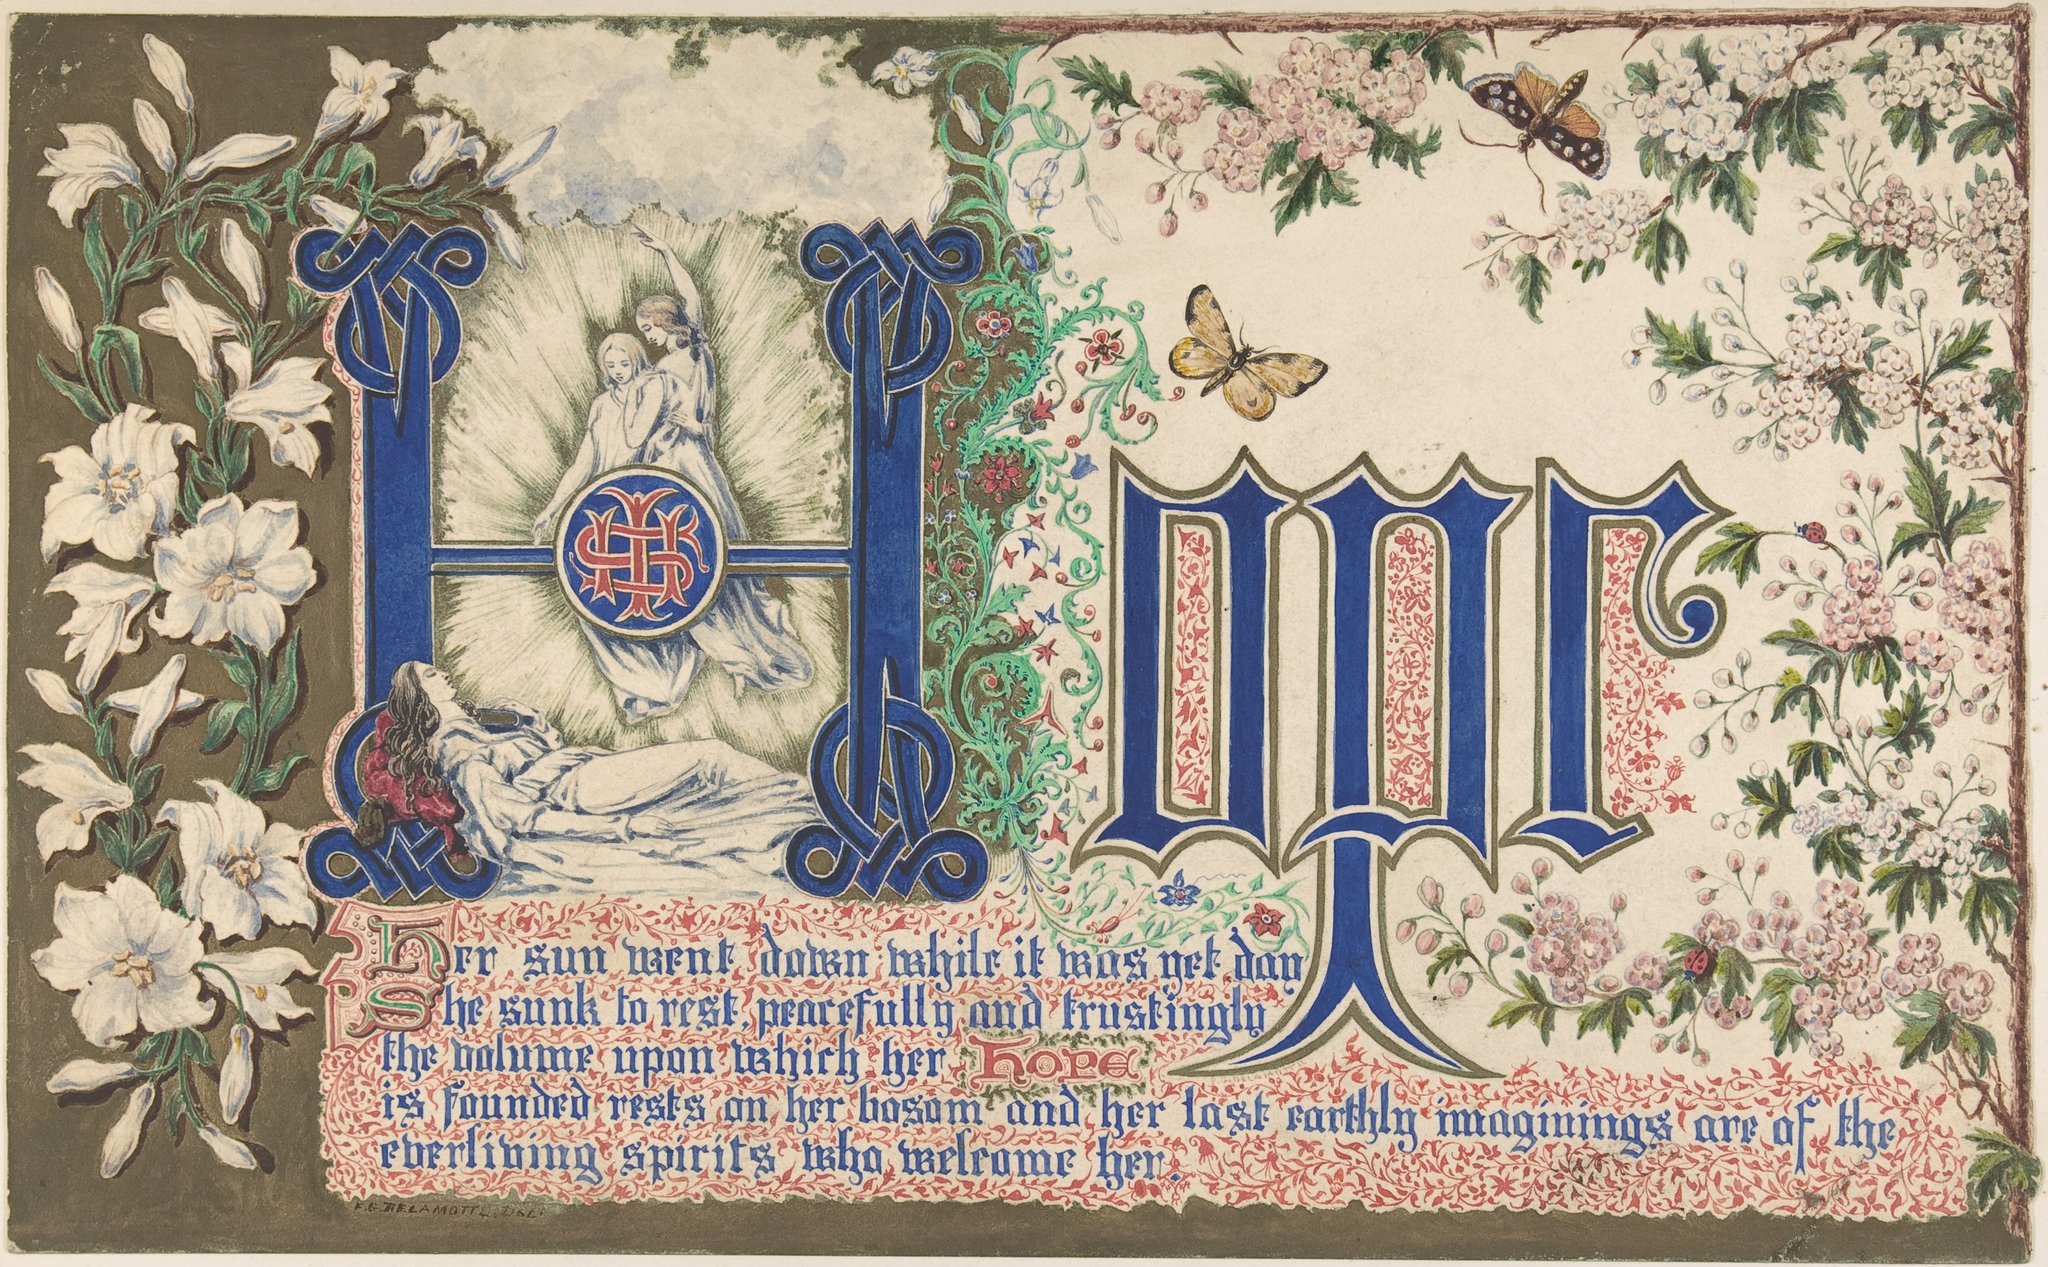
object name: drawing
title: Hope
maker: freeman gage delamotte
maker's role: artist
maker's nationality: british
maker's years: 1813-1862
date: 1830-1862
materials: gold, gouache, watercolor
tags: human figures,butterflies,flowers,leaves